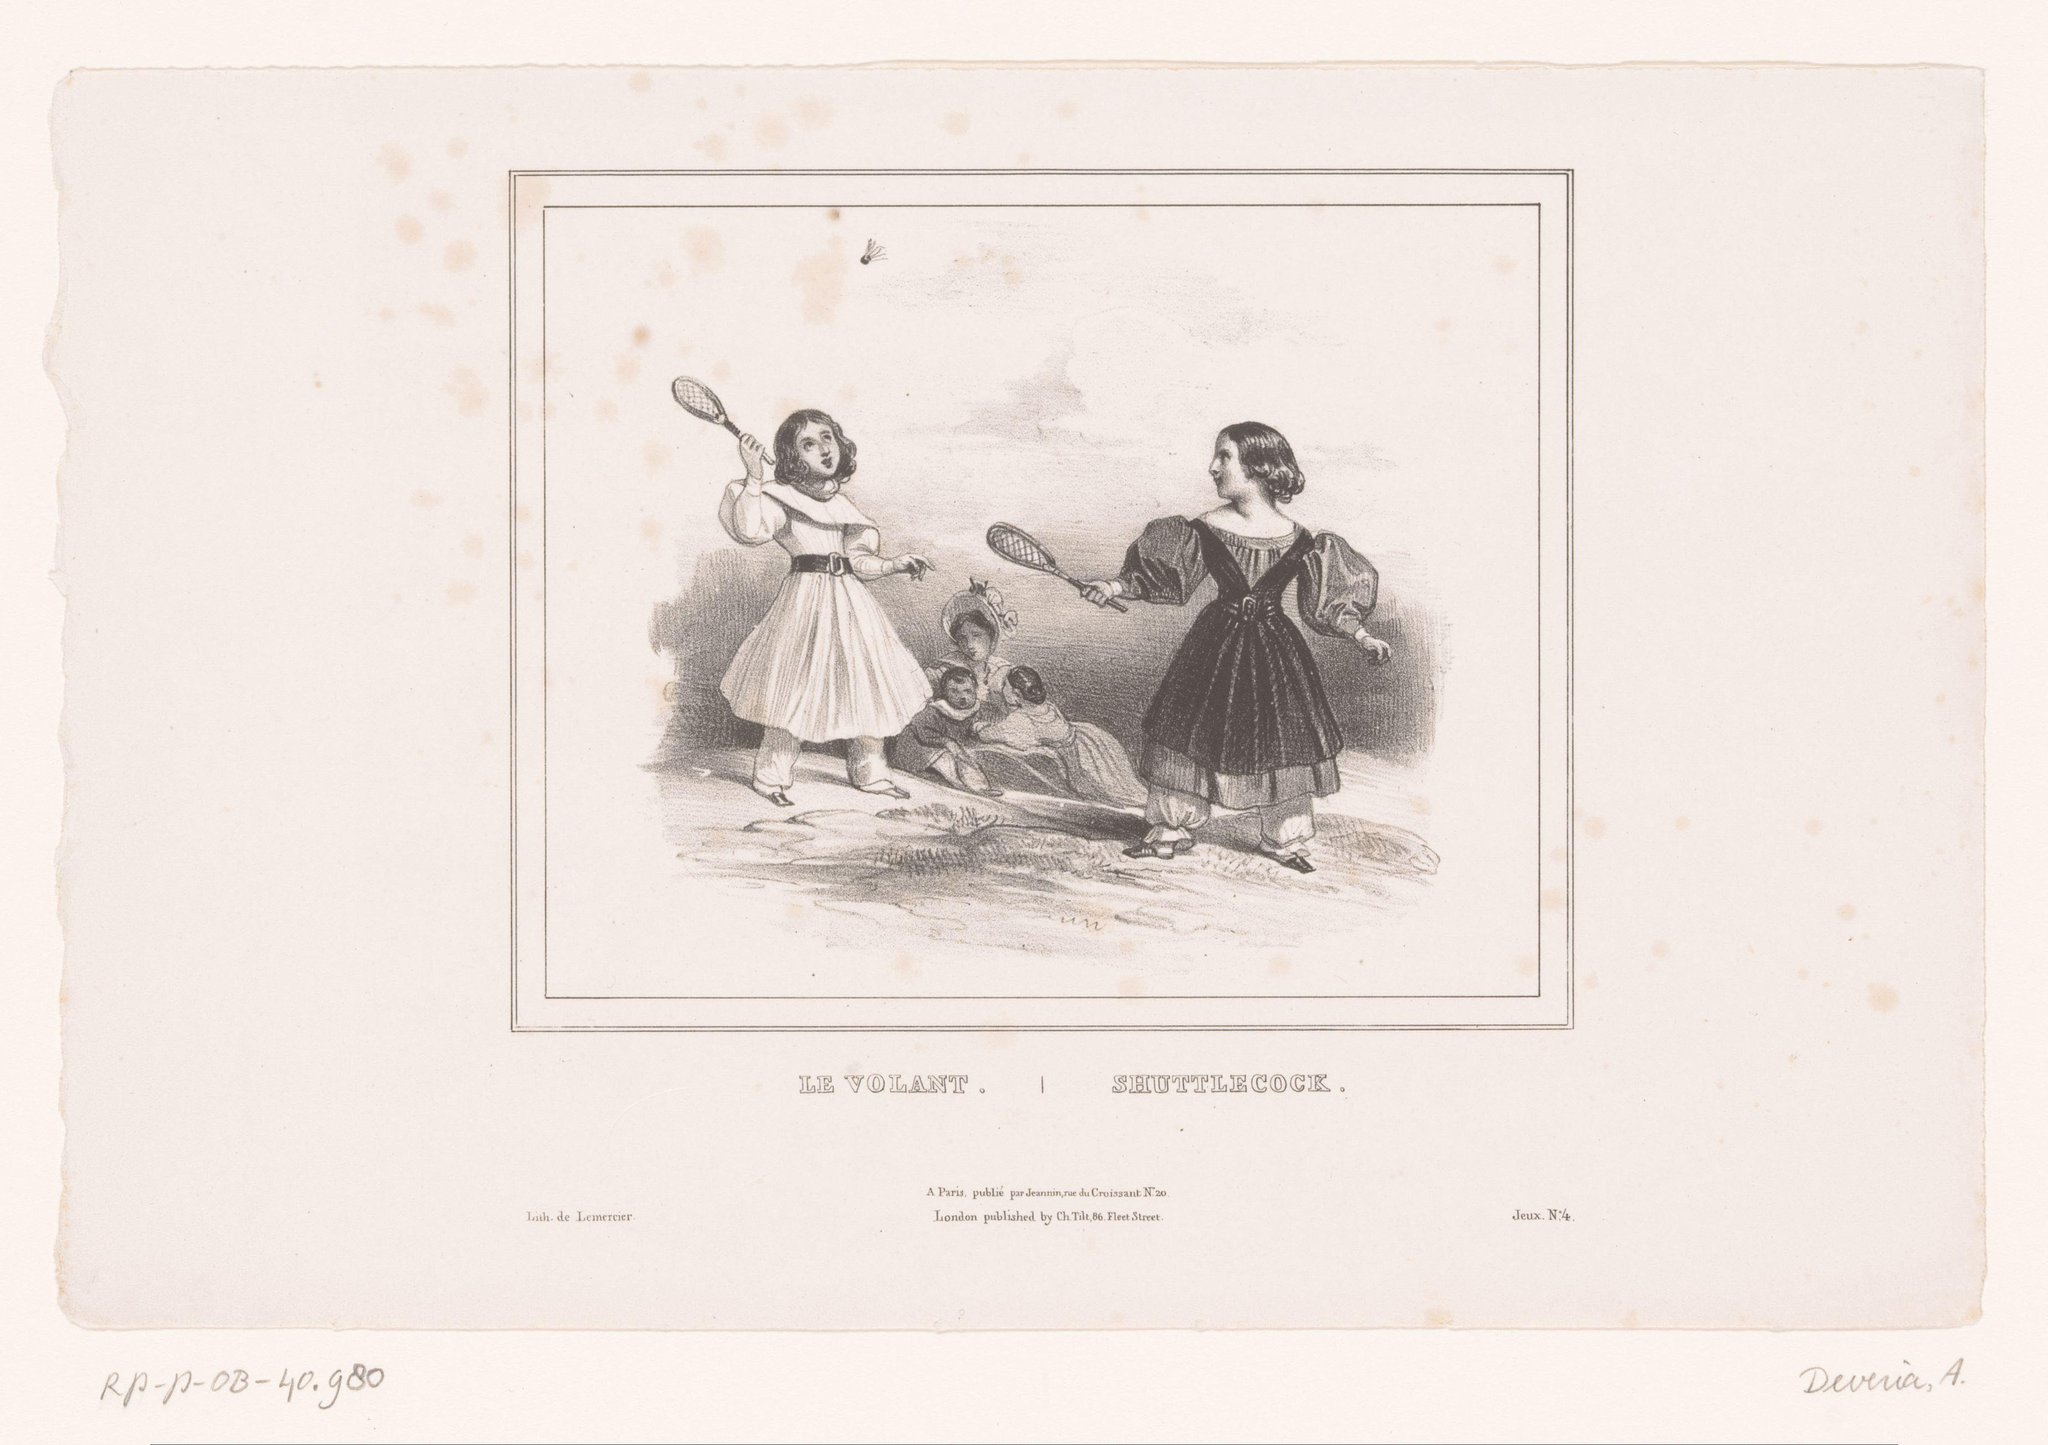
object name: print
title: Jeux d'enfants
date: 1832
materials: paper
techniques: lithograph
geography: paris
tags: child, 'jeu de volant', badminton, games using special objects (marbles, top, hoop, etc.)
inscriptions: check stamp: Lugt 1397c, collector's mark: Lugt 2166